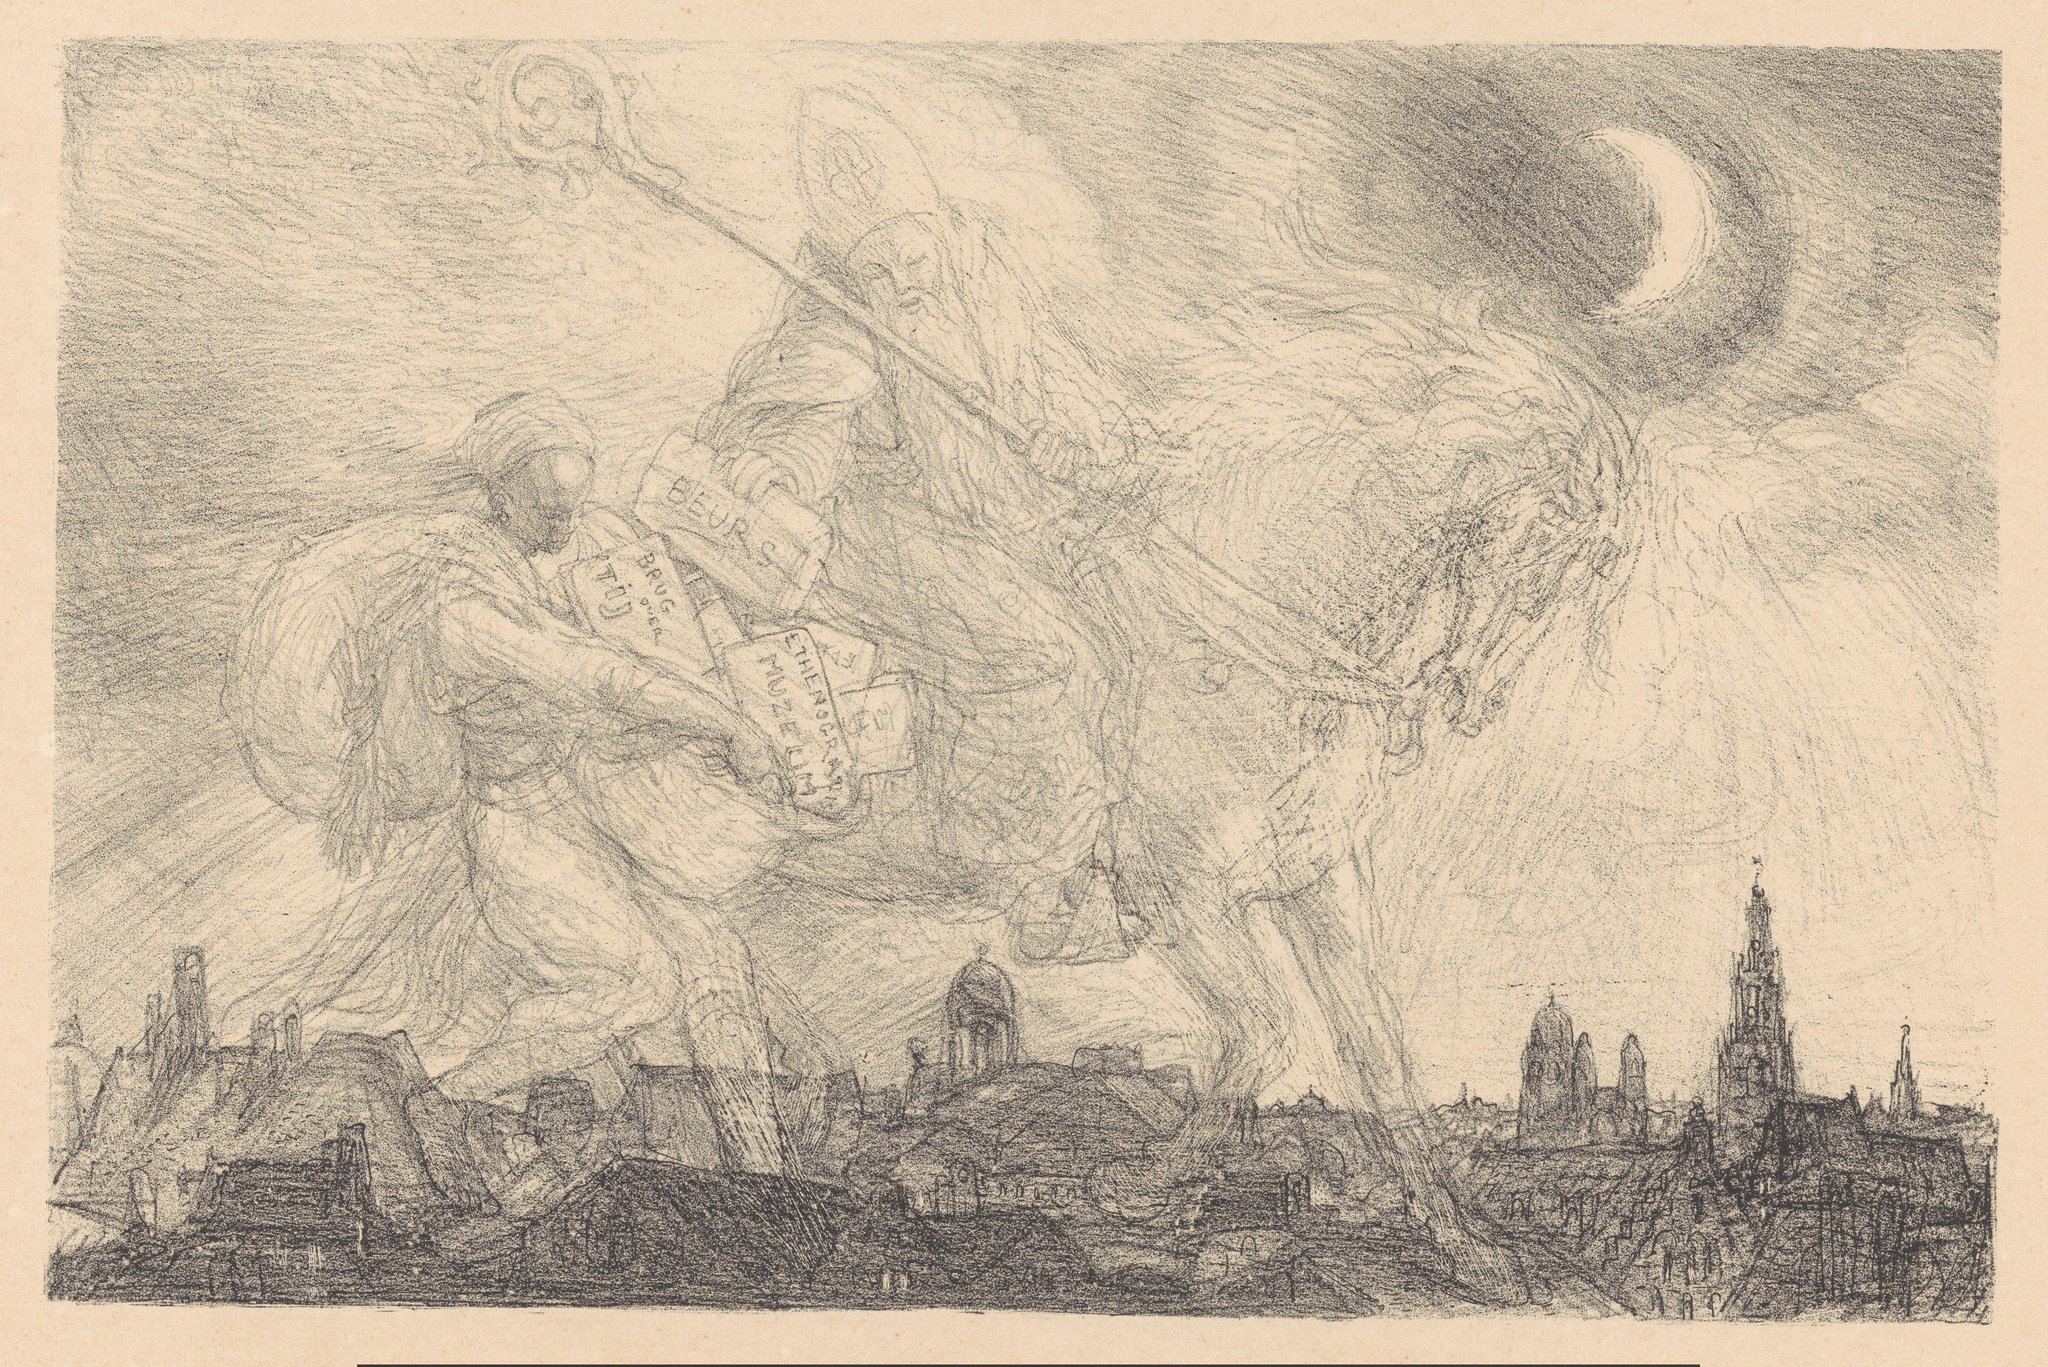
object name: cartoon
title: St. Nikolaas te Amsterdam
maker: marius bauer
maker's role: draughtsman, print maker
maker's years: 1867-1932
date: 1895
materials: paper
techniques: lithograph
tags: the bishop nicholas of myra (or bari); possible attributes: anchor, boat, three golden balls (on a book), three purses, three children in a tub, three maidens, political caricatures and satires, amsterdam, saint nicholas day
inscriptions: collector's mark: Lugt 2228, collector's mark: Lugt 2760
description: Spotprent waarin Sinterklaas een pakje waarop Beurs geschreven is in de zak met cadeaus van Zwarte Piet stopt. Verwijst naar de bouwplannen voor een nieuwe beurs en andere gebouwen in Amsterdam in 1895. Verschenen in het bijvoegsel van 'De Kroniek' van 8 december 1895.